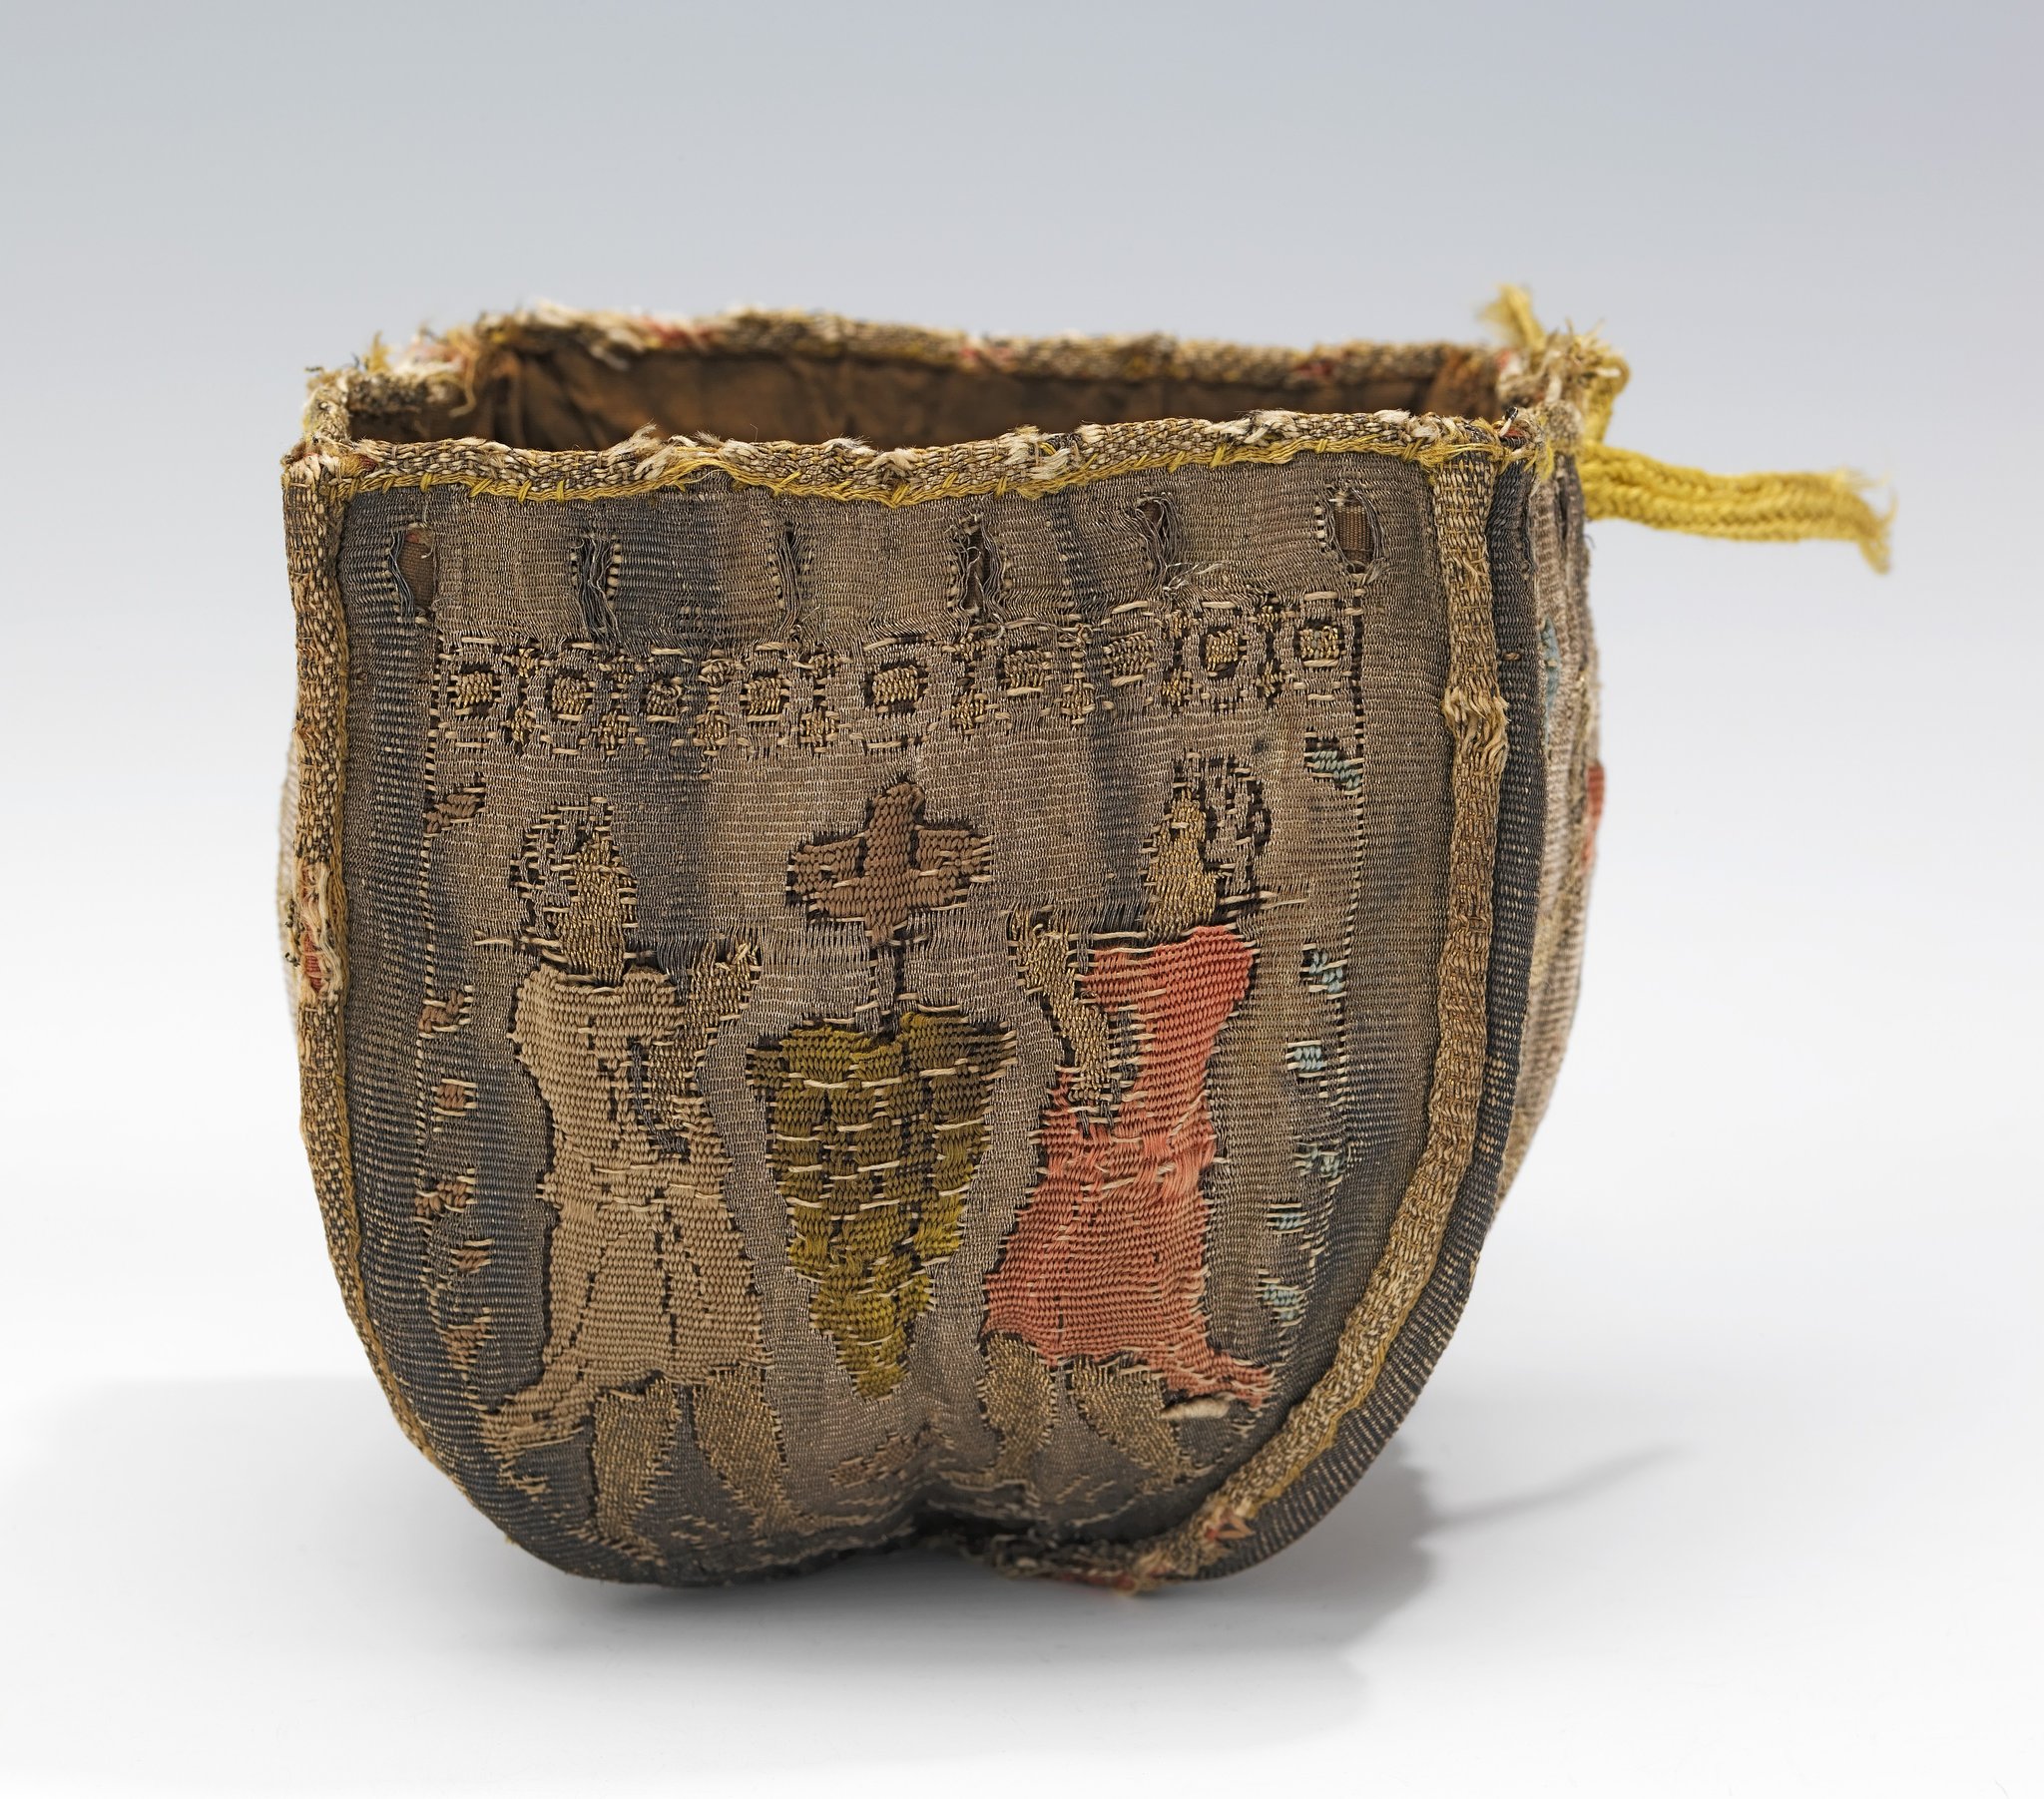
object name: purse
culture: french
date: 1676-1700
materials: metal, silk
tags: human figures